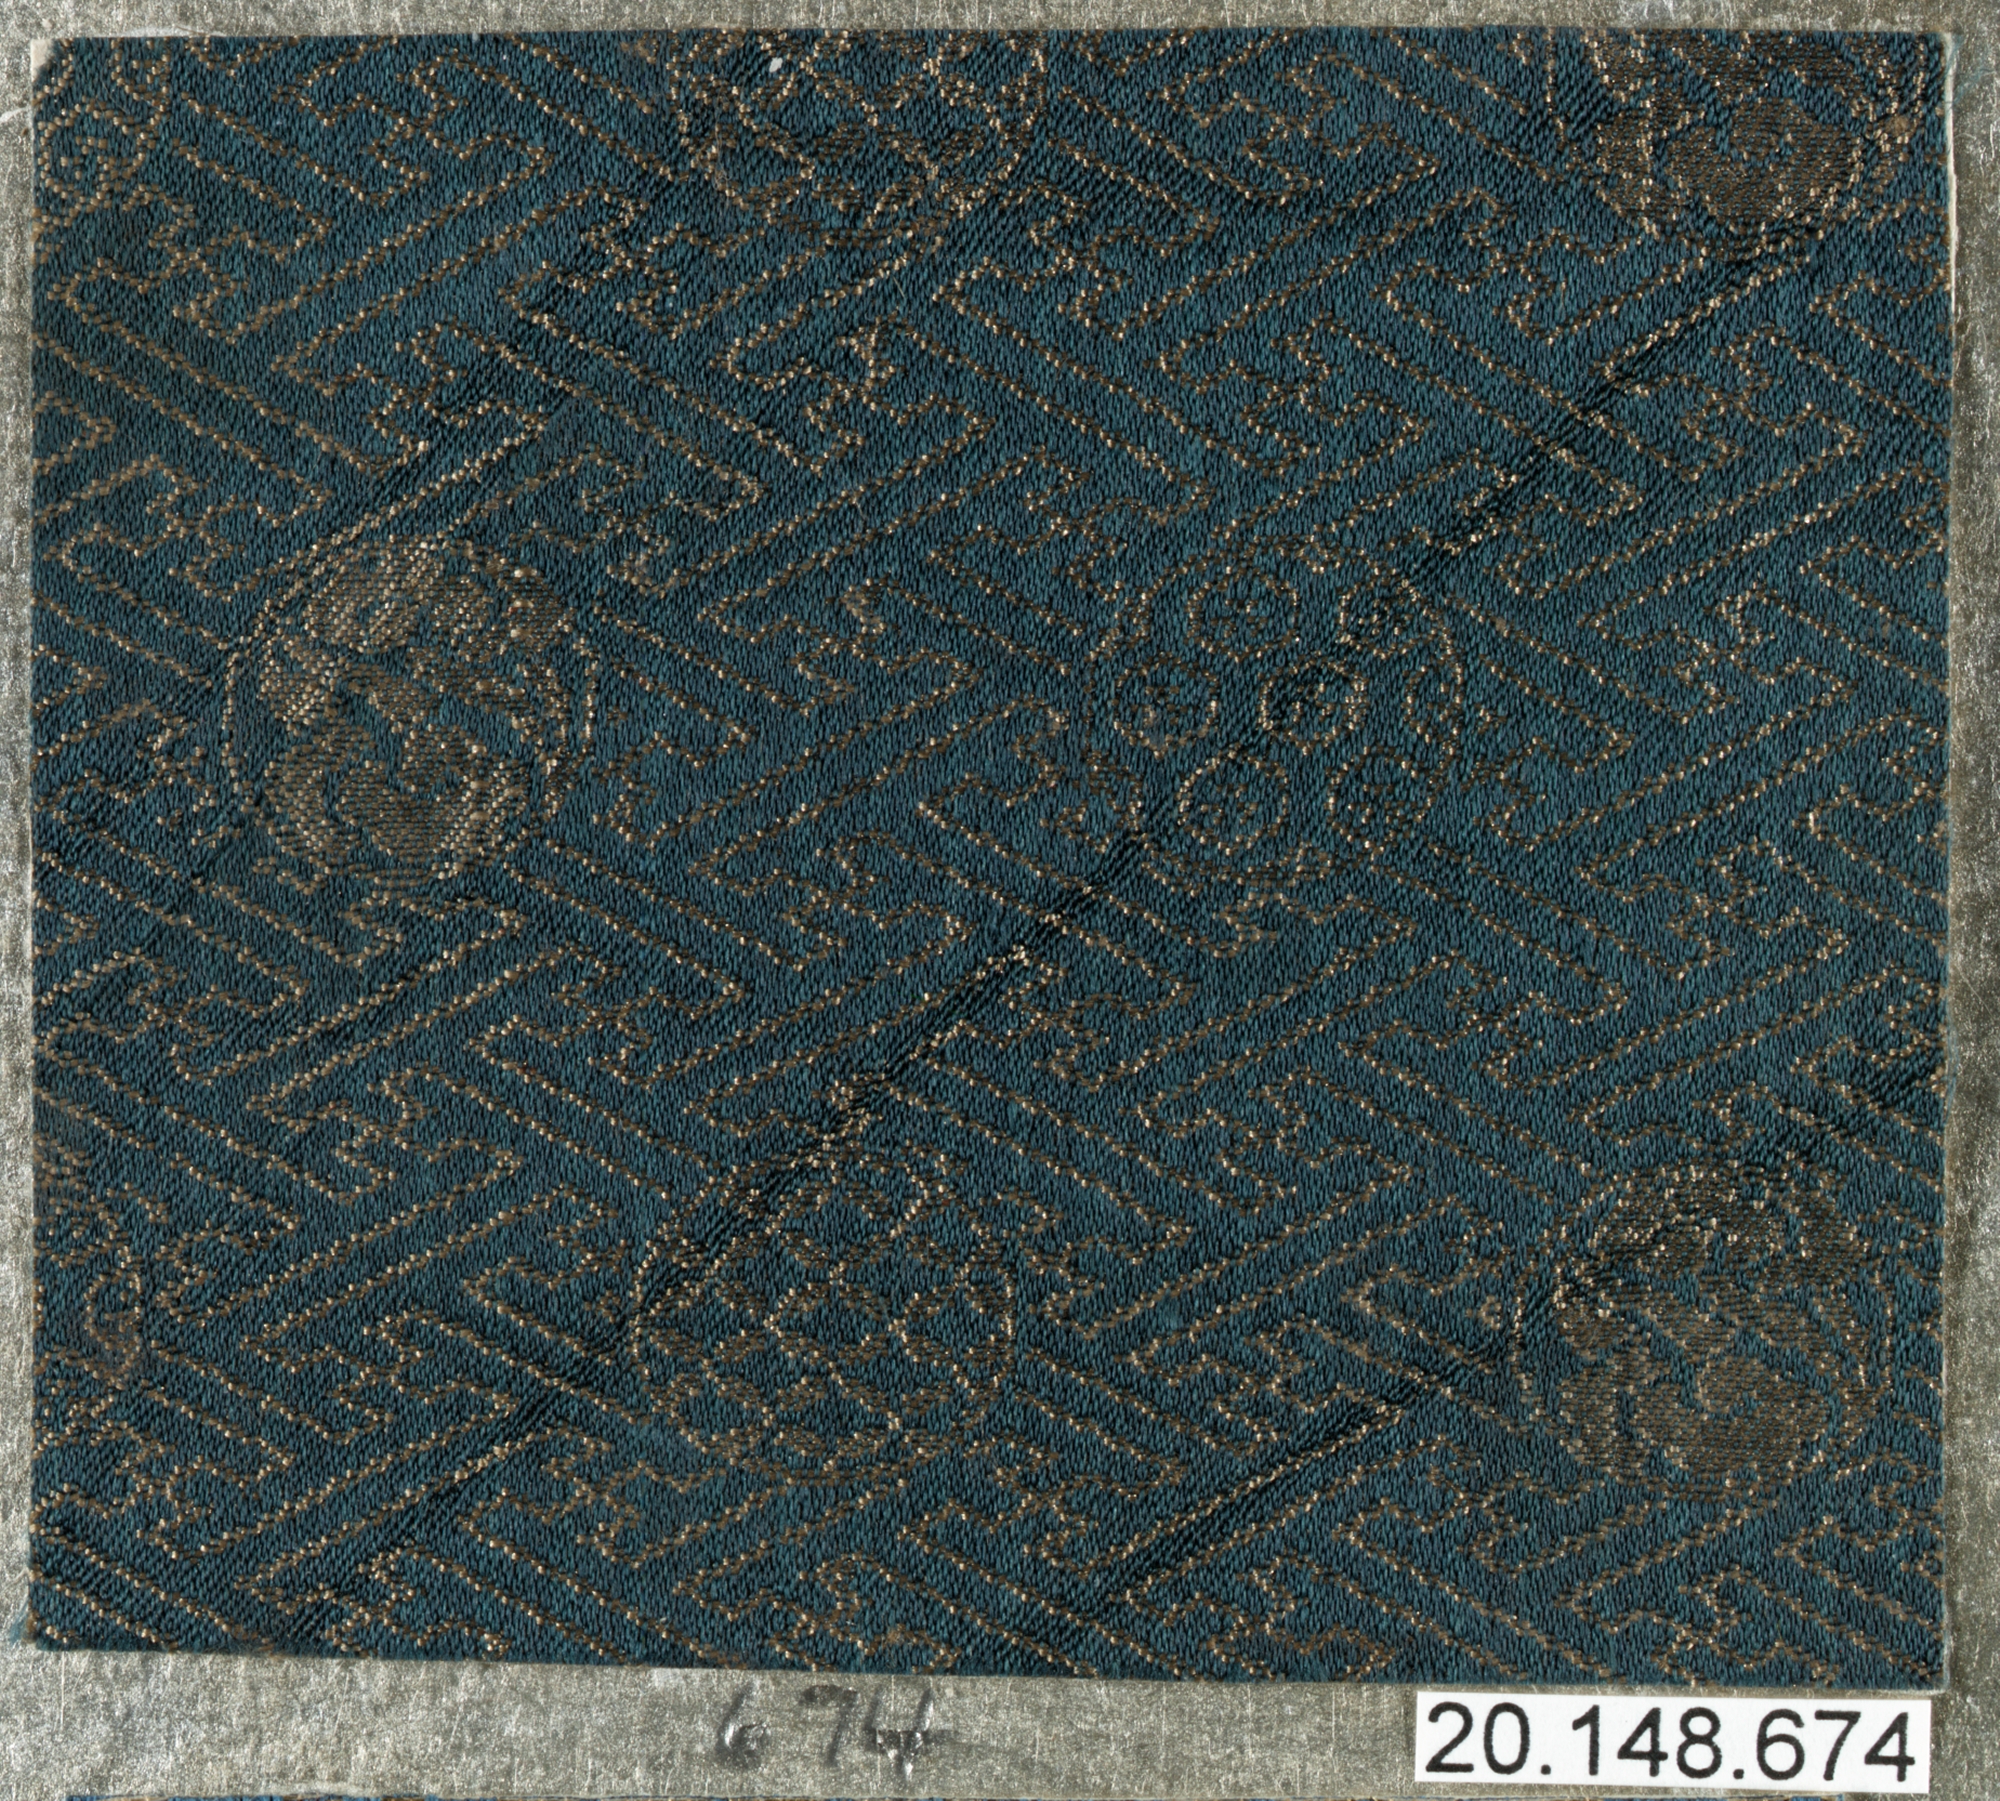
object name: piece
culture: japanese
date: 1701-1800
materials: silk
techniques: compound weave